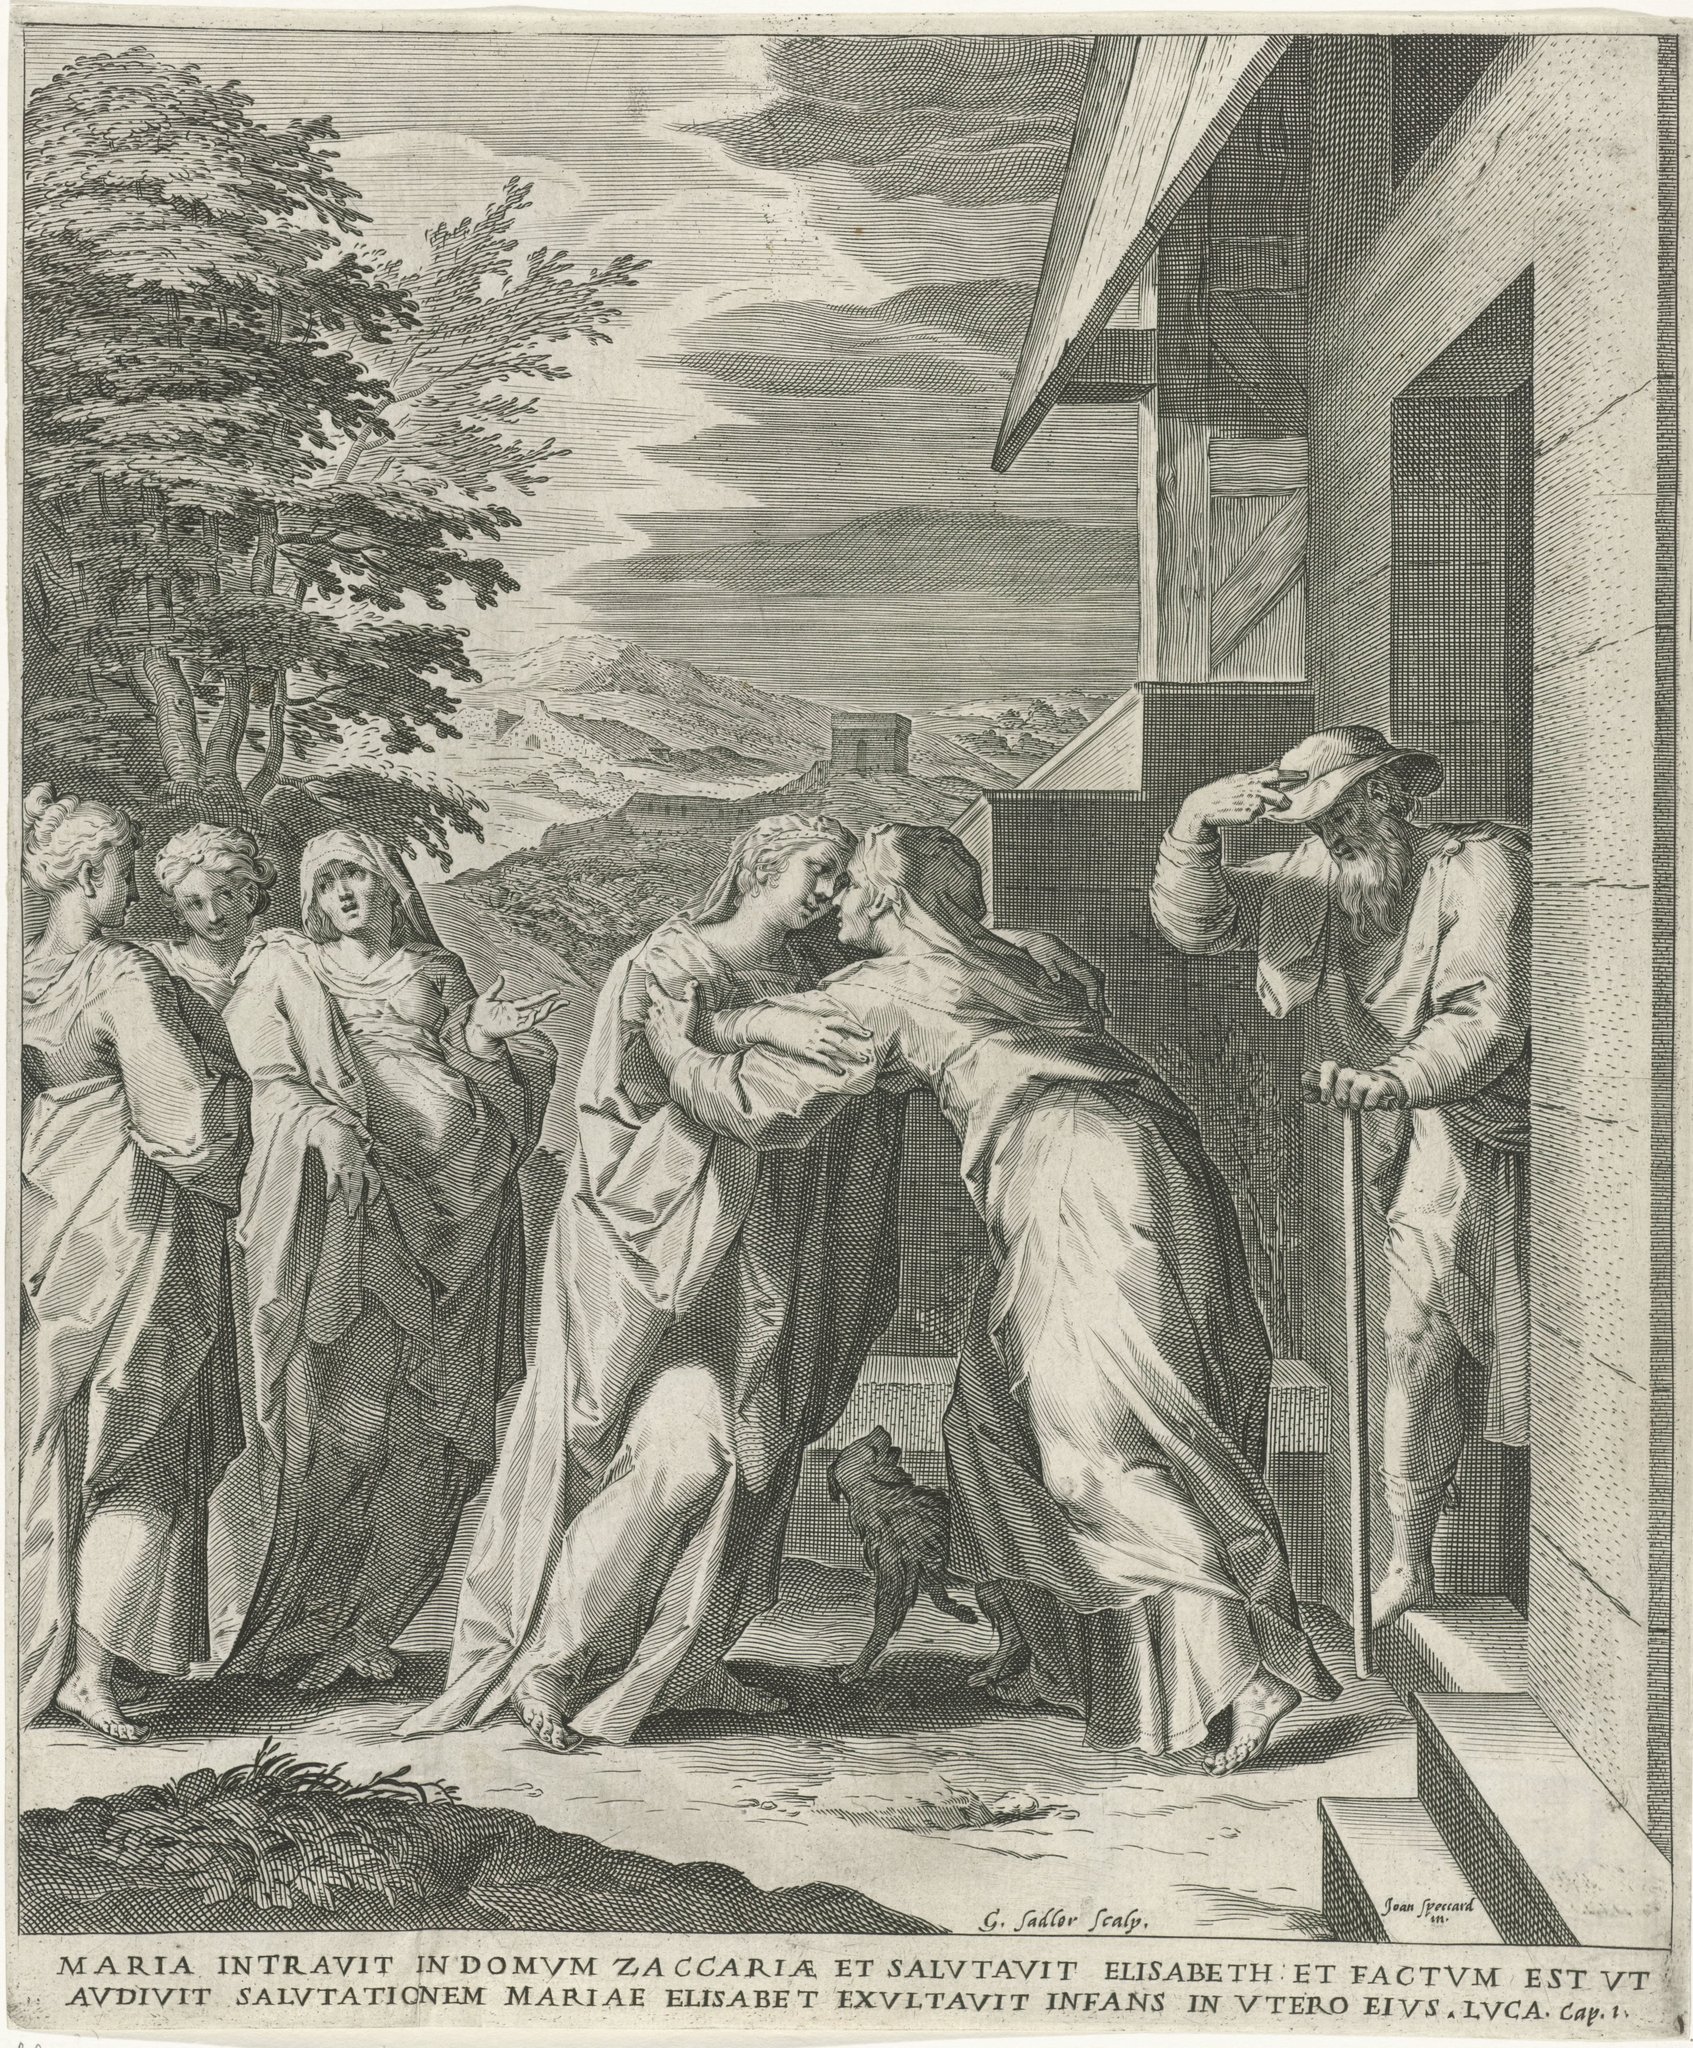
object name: print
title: Leven van Maria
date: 1580-1629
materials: paper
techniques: engraving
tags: mary and elisabeth, both pregnant, embracing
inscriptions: collector's mark: Lugt 11, number: ‘1’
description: Bezoek van Maria aan haar nicht Elisabet. De twee omhelzen elkaar. Zacharias staat achter zijn vrouw. De prent heeft een Latijns onderschrift.